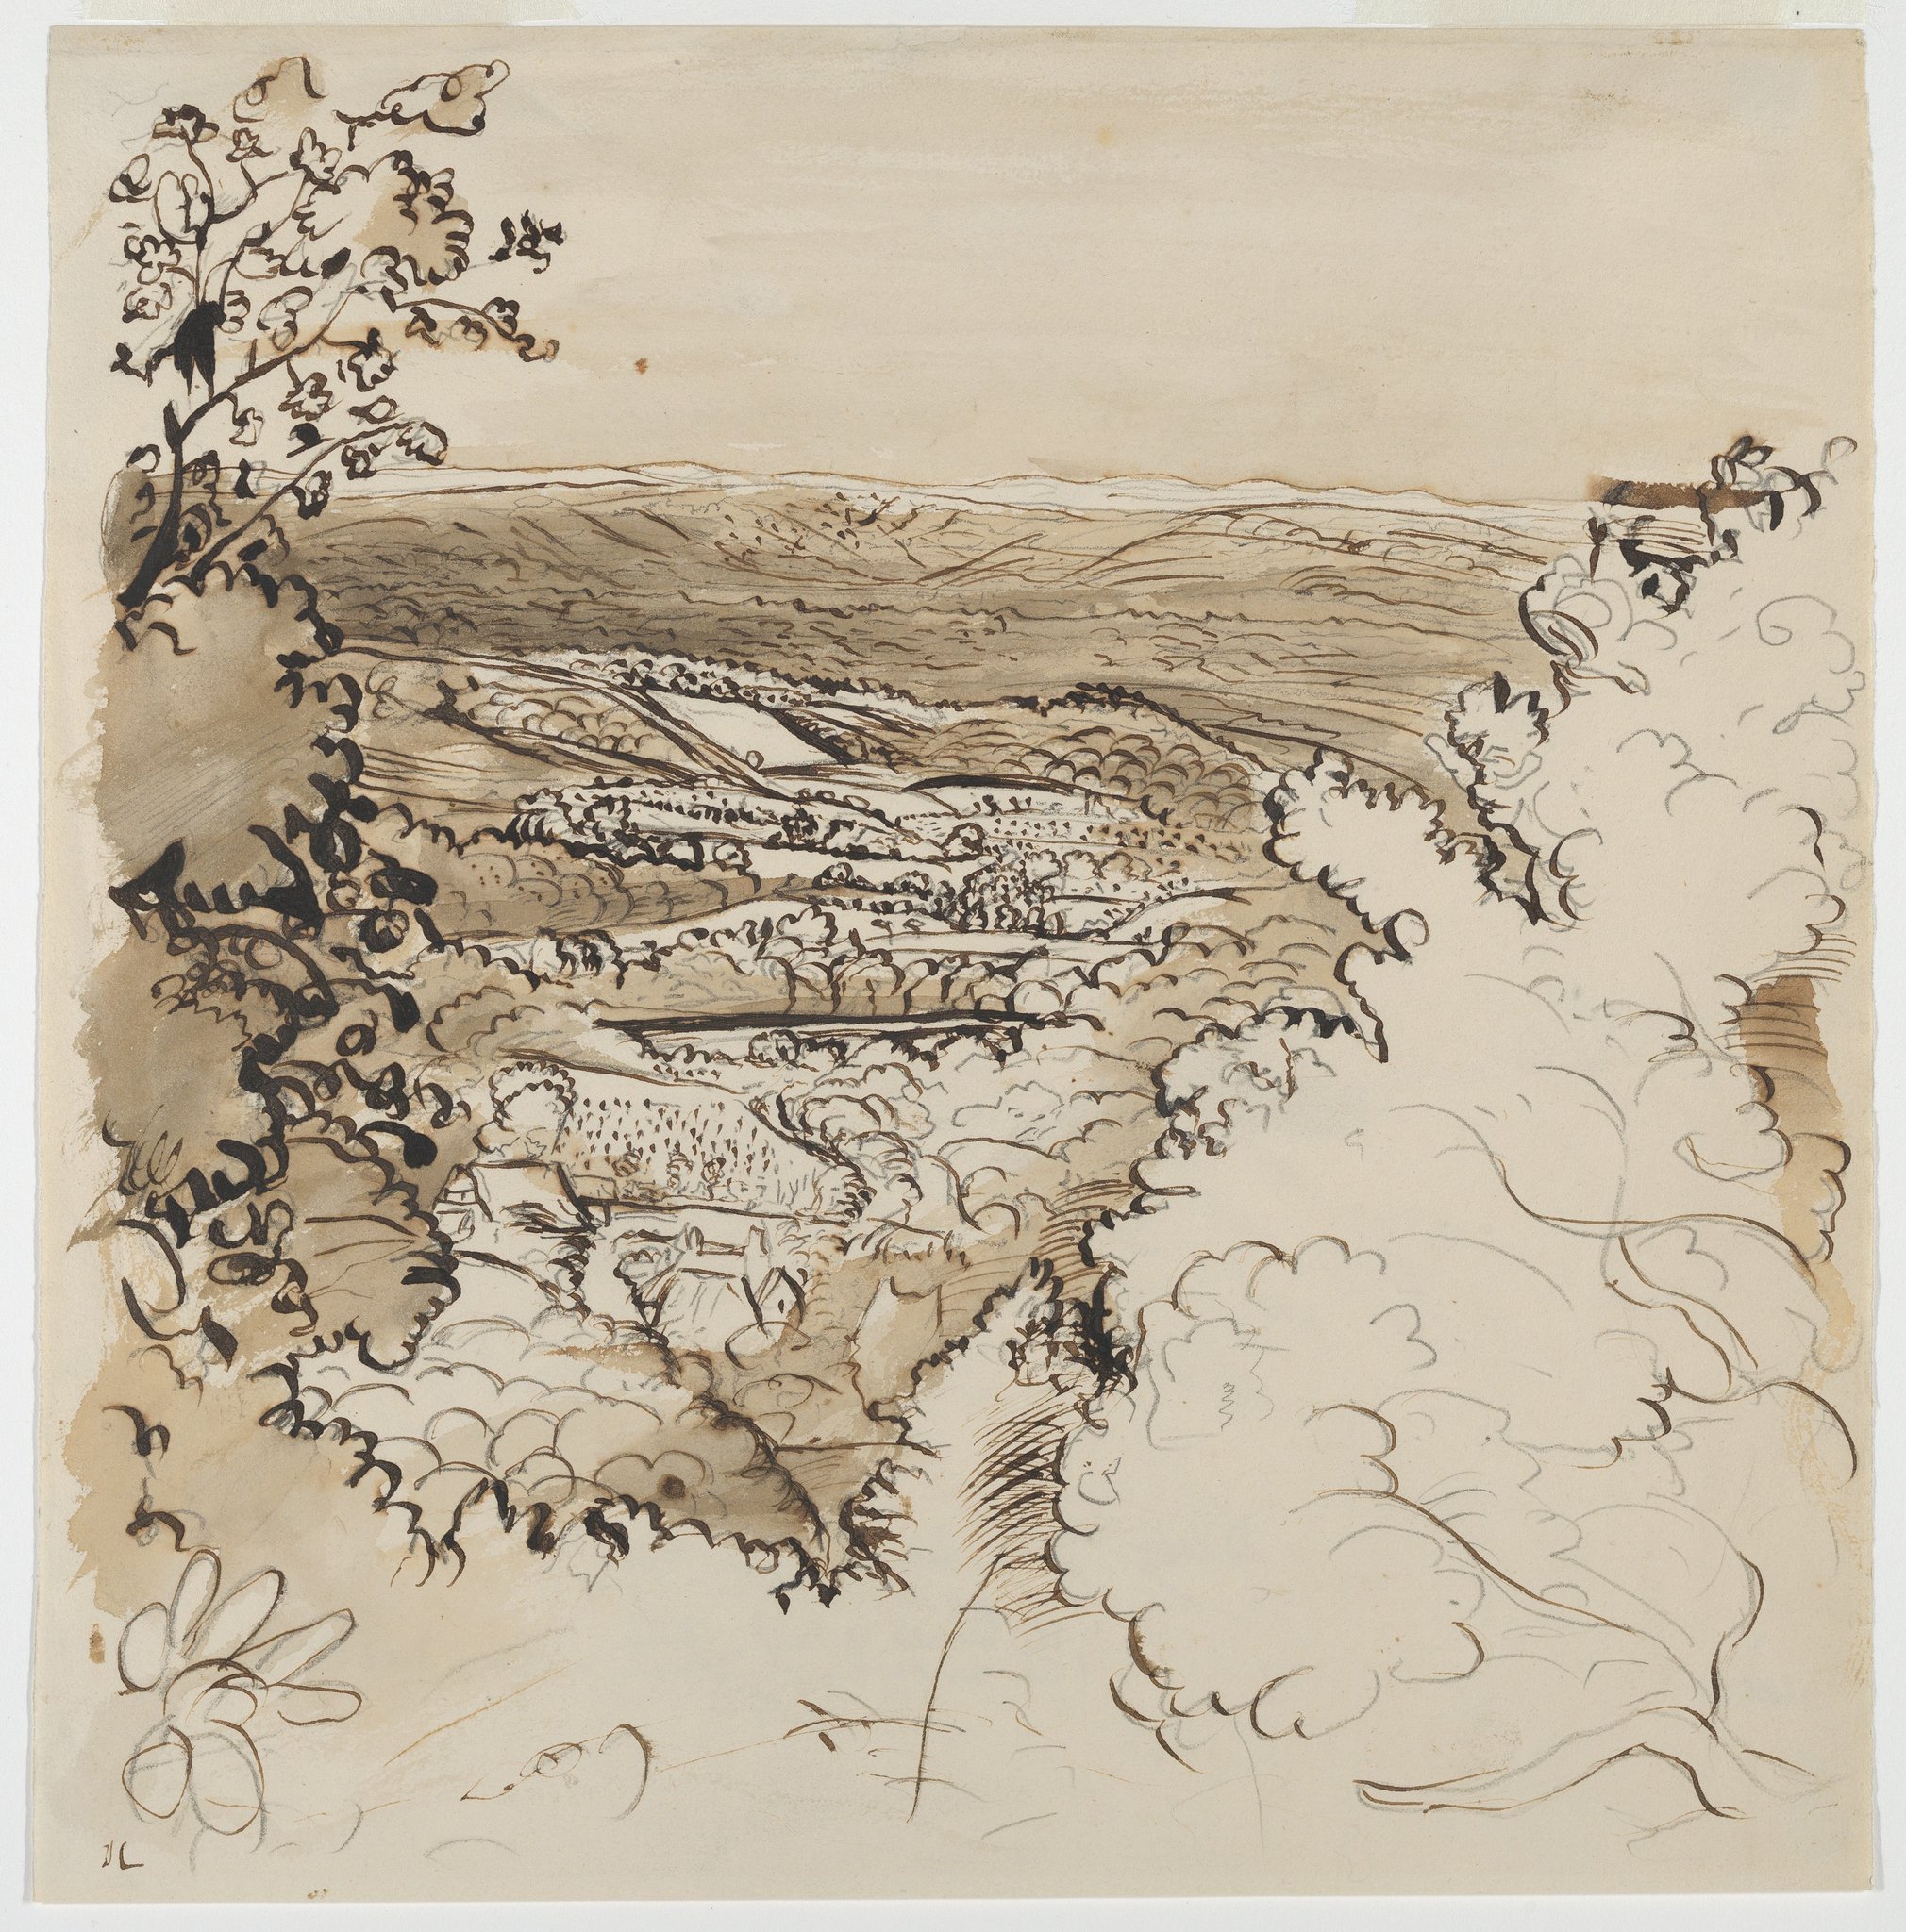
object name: drawing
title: Underriver–The Golden Valley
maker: john linnell (ii)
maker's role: artist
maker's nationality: british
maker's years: 1792-1882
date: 1833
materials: graphite, ink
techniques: brush, pen, wash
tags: hills,landscapes,trees